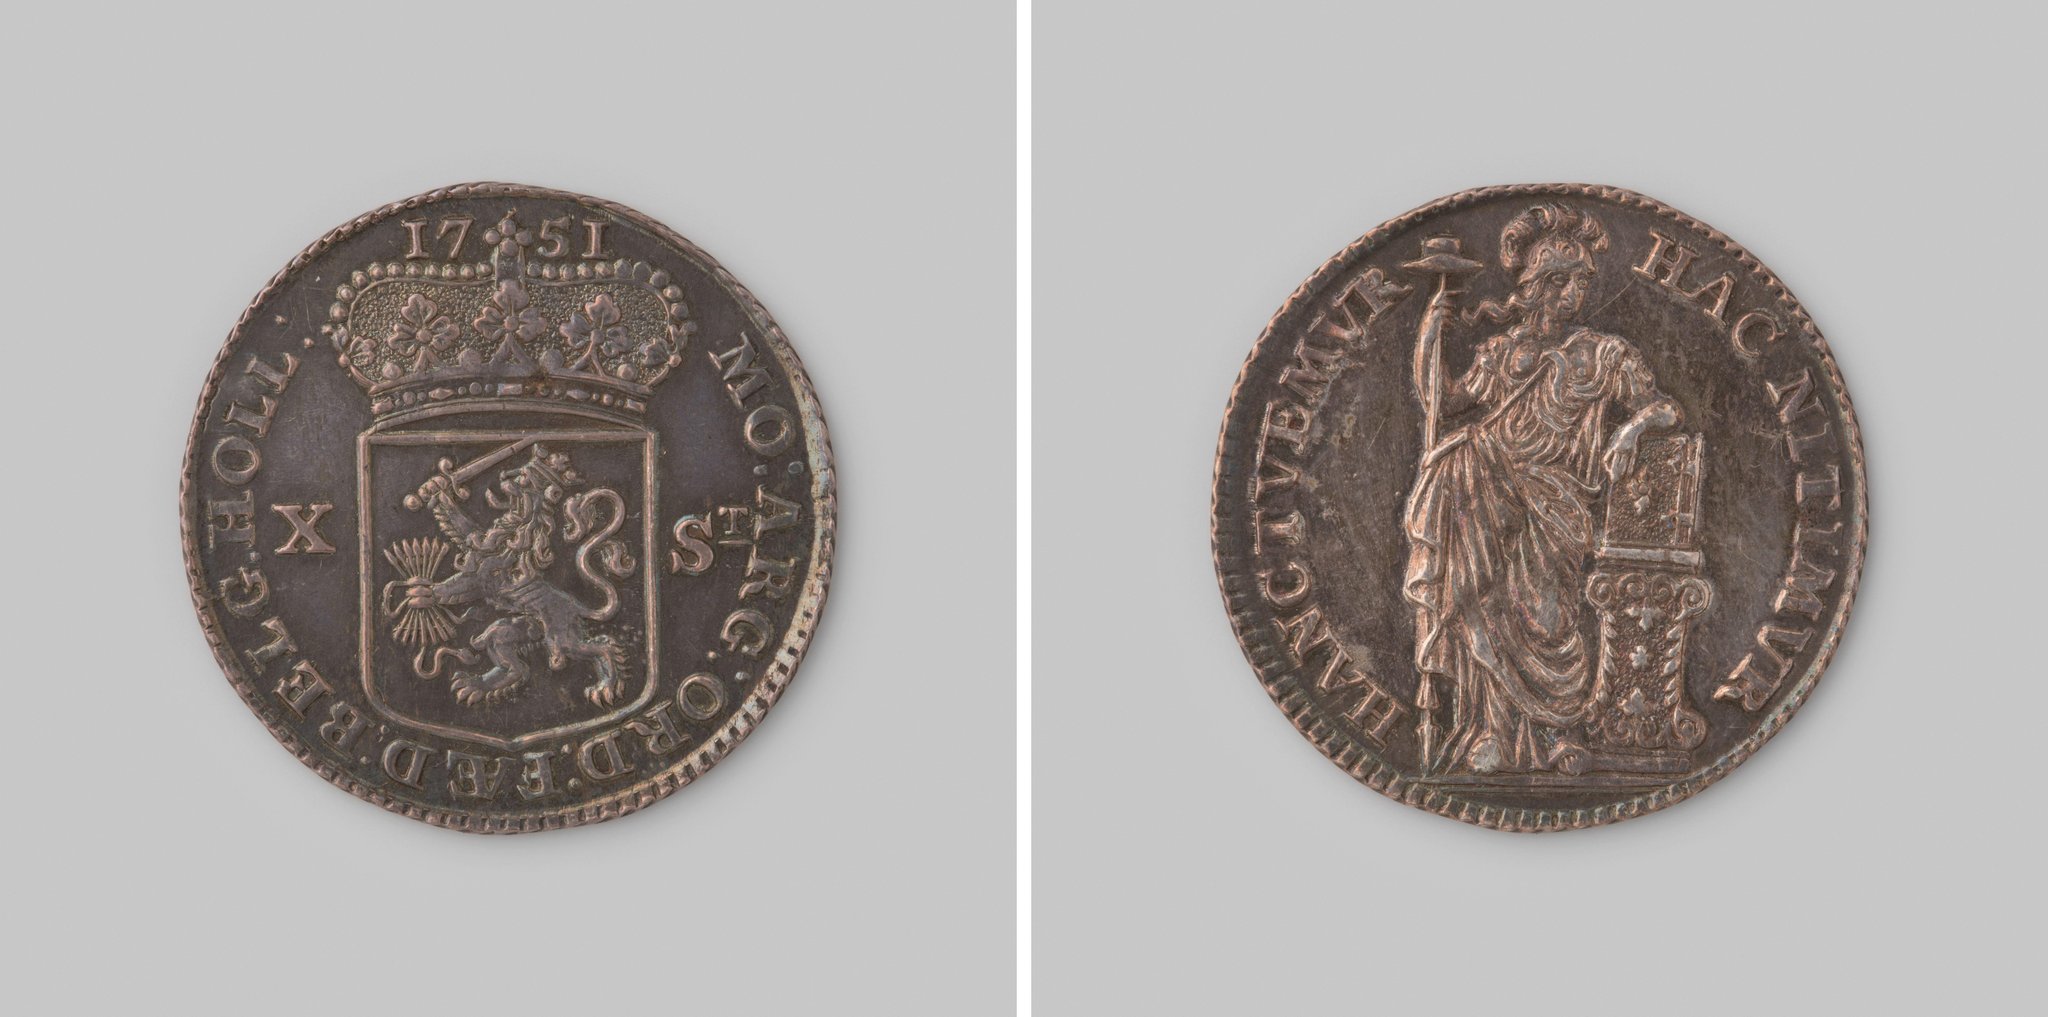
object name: coin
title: Hollandse halve gulden, 1751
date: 1751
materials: silver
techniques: striking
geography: dordrecht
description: Zilveren munt. Voorzijde: tussen waarde-aanduiding X St gekroond generaliteitswapenschild. Jaartal boven kroon. Keerzijde: staande Nederlandse maagd met in rechterhand speer, waarop hoed en met linkerhand steunend op altaar, waarop bijbel. Met kabelrand